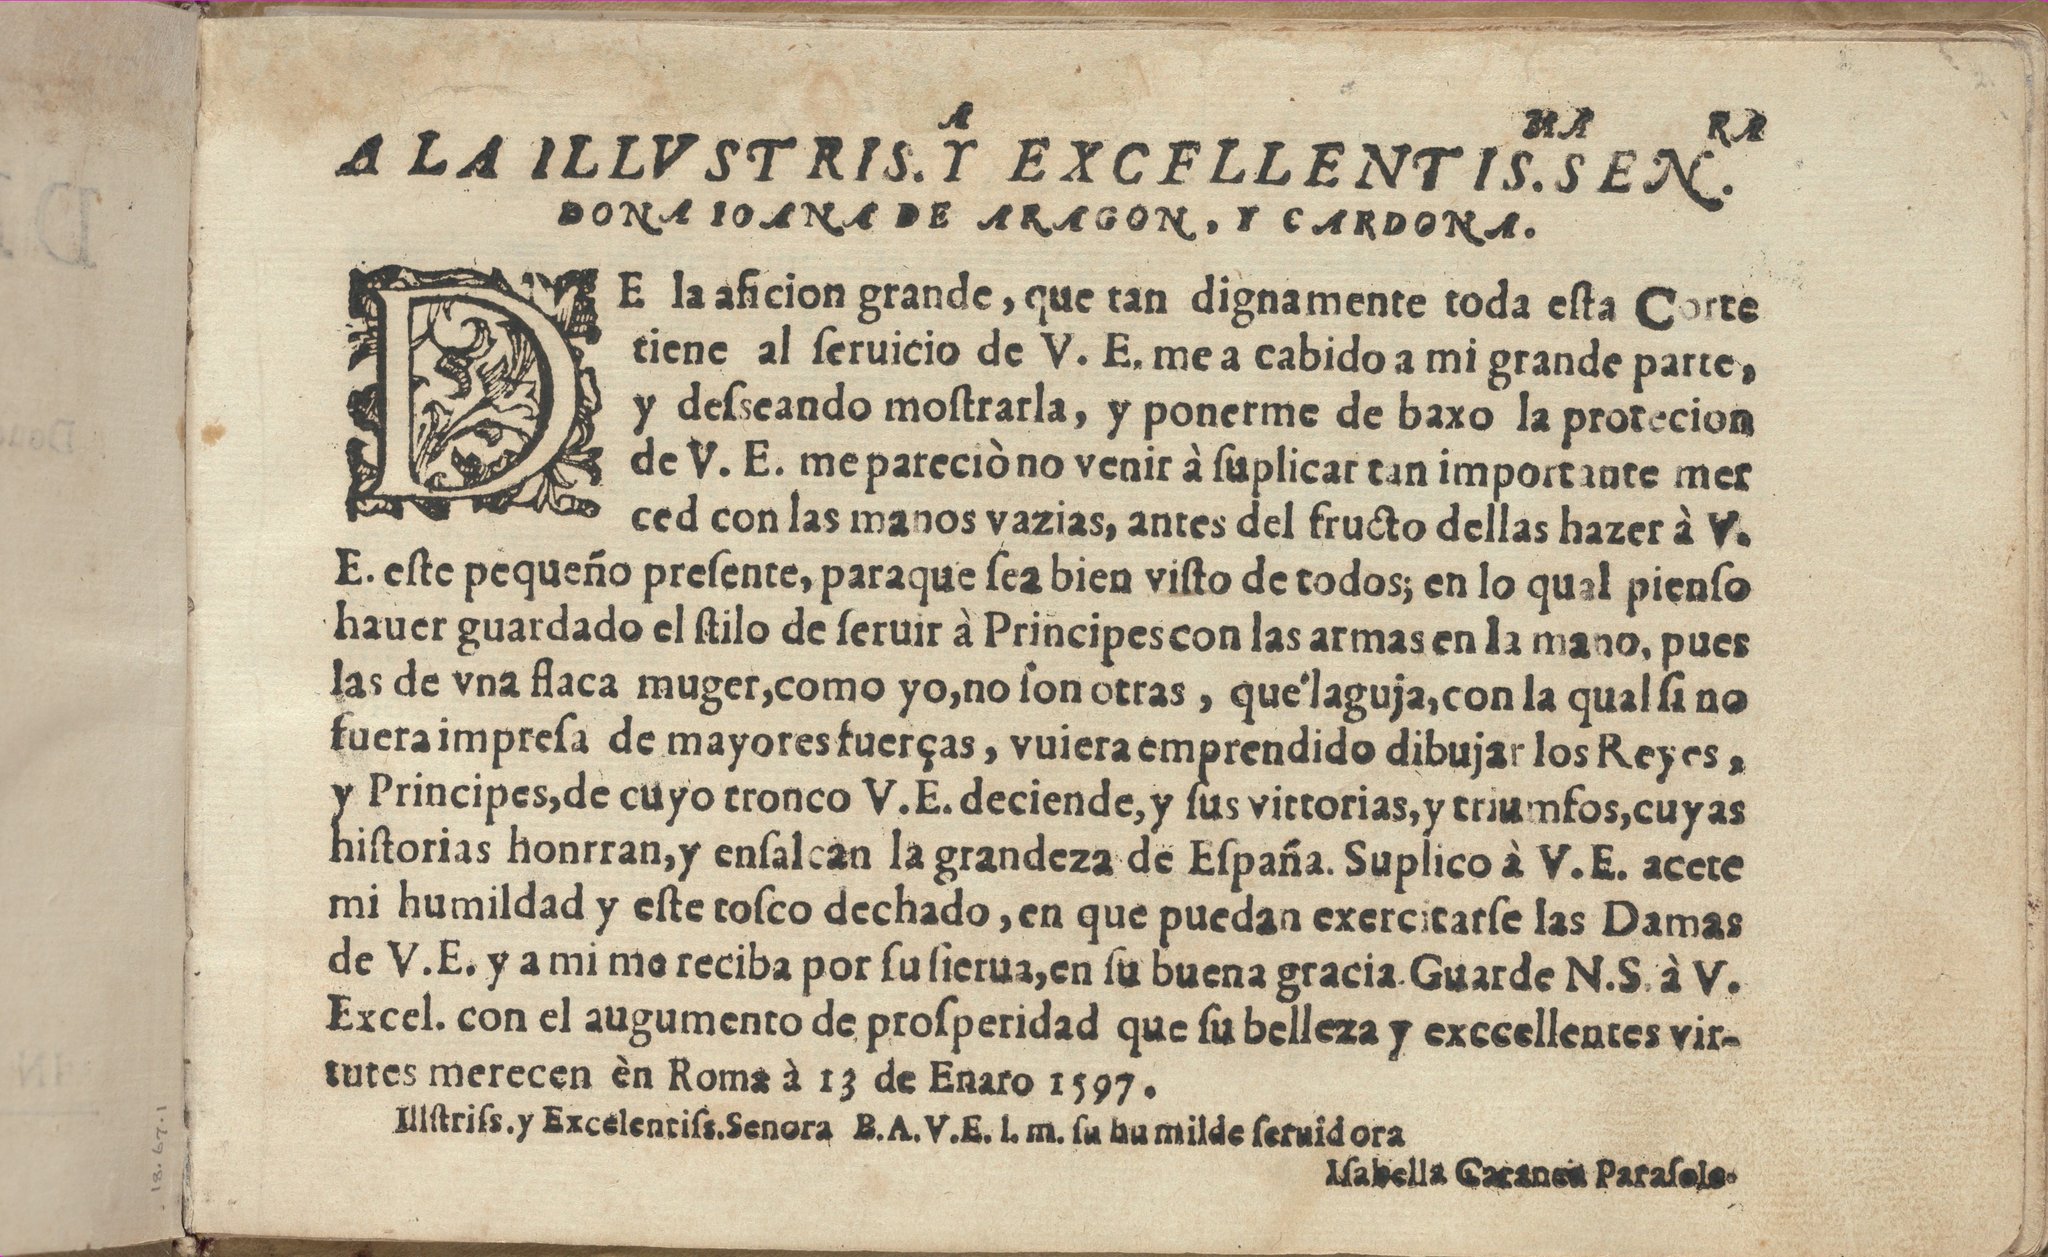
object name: book print ornament architecture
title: Studio delle virtuose Dame, page 2 (recto)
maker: isabella catanea parasole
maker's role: designer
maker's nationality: italian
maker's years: 1565-1625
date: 1597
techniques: woodcut